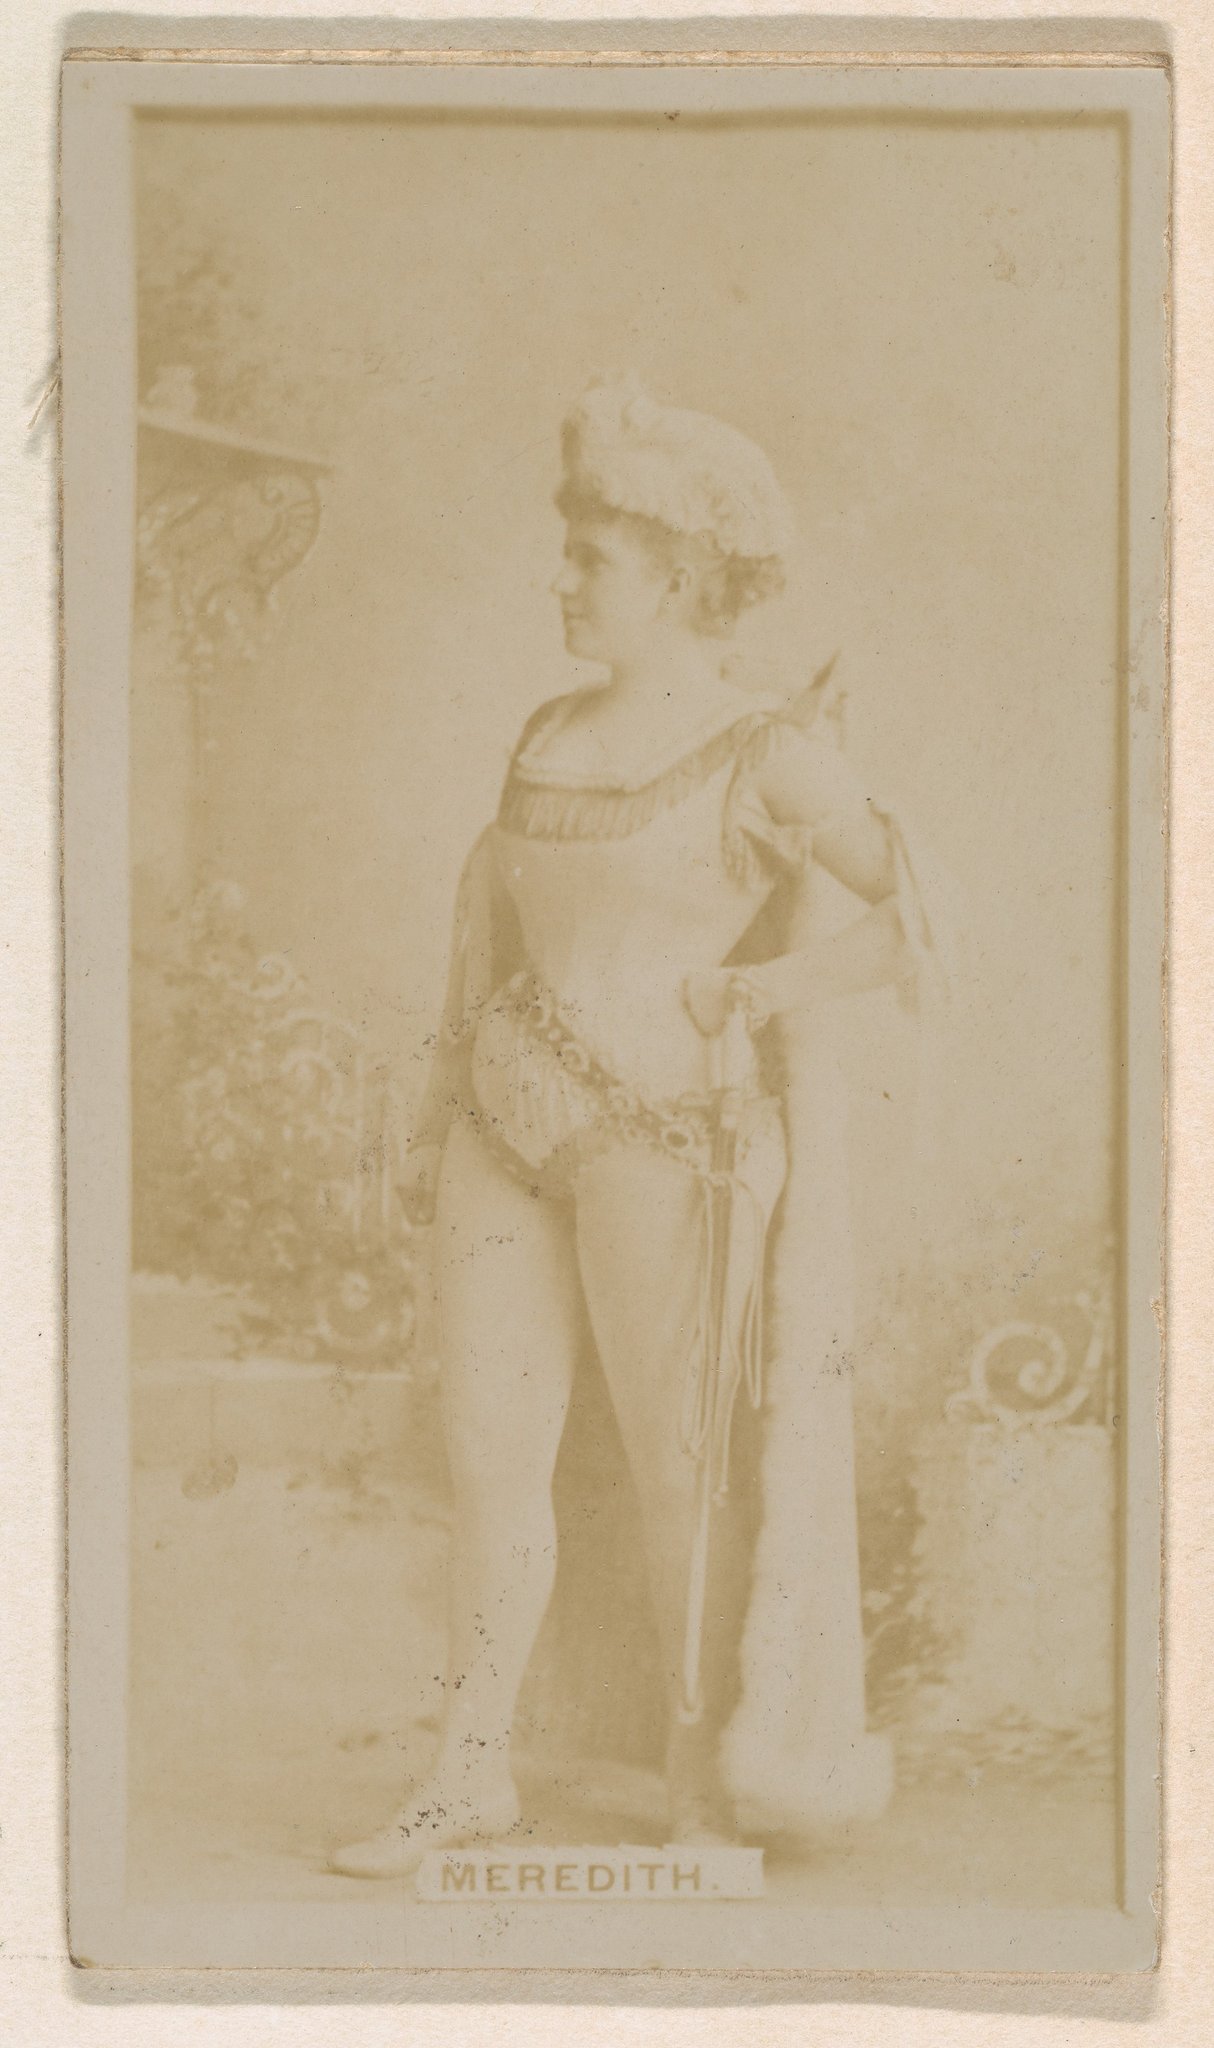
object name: photograph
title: Miss Meredith, from the Actresses series (N245) issued by Kinney Brothers to promote Sweet Caporal Cigarettes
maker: kinney brothers tobacco company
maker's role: publisher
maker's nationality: american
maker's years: 1869-2011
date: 1890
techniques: albumen silver print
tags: women,actresses